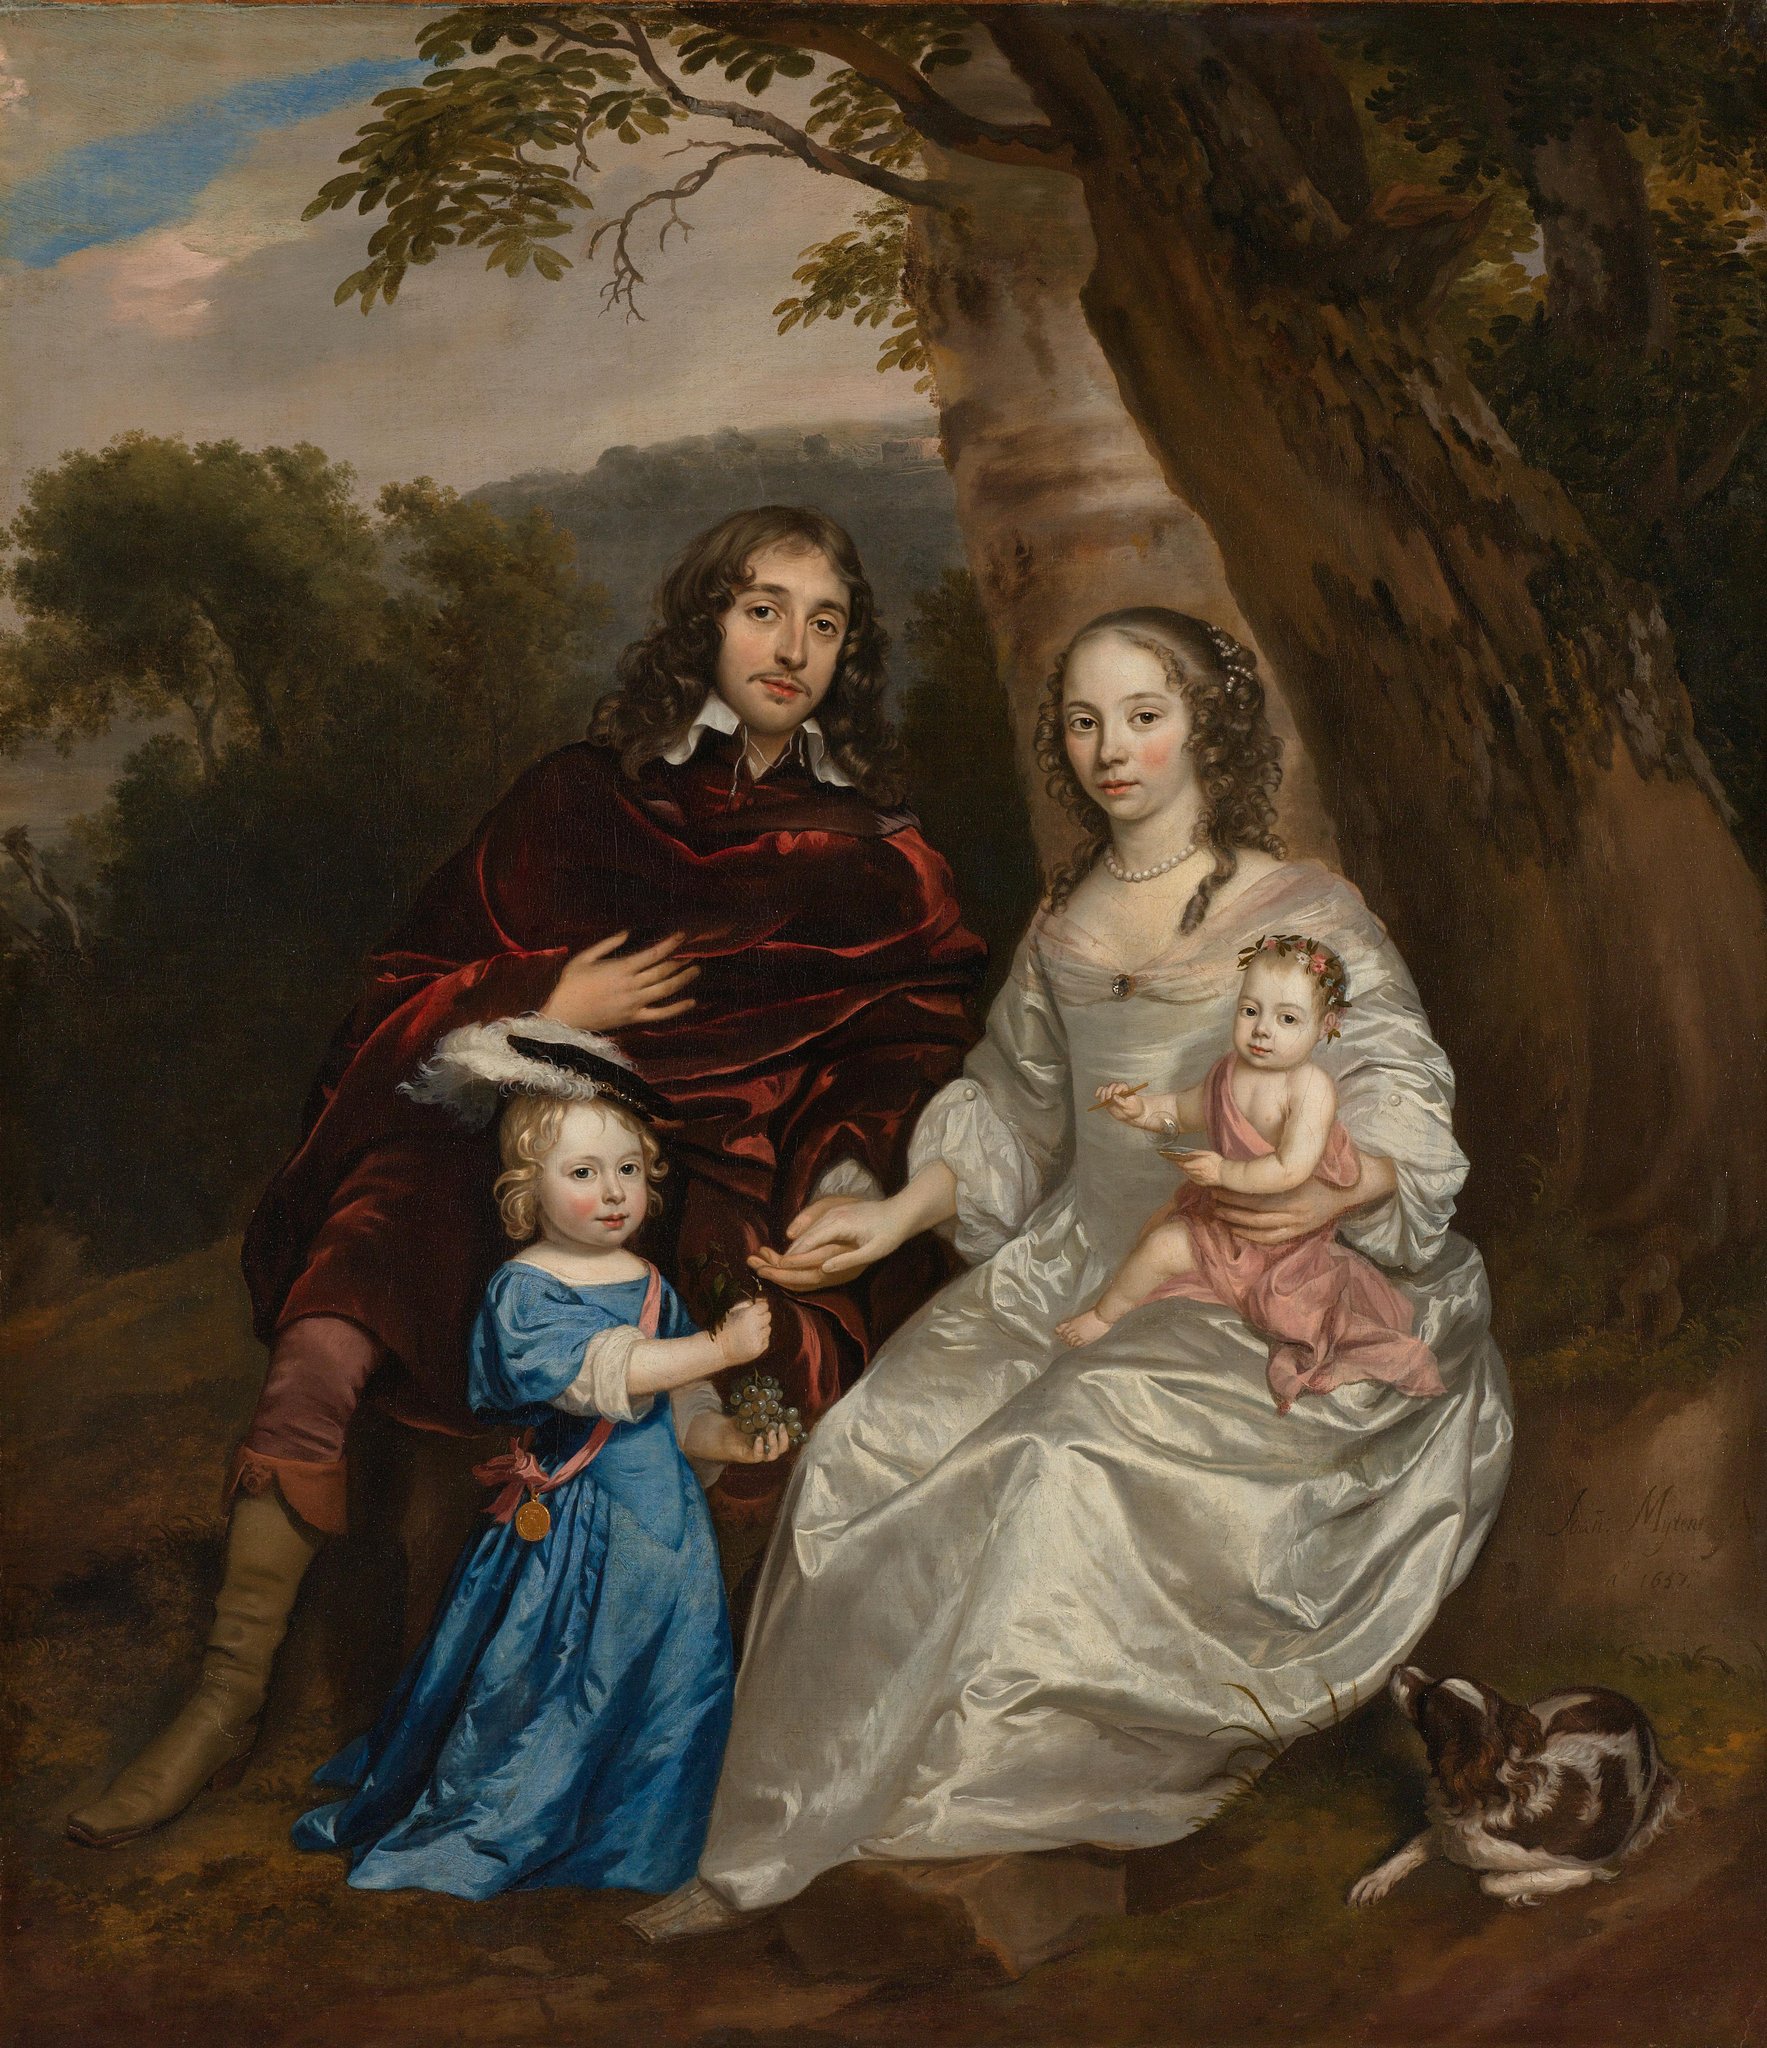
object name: painting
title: Portrait of Govert van Slingelandt (1623-1690), with his First Wife Christina van Beveren (1632-1656) and their Two Children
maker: jan mijtens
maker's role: painter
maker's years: 1614-1670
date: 1657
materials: canvas, oil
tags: dordrecht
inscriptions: signature and date, lower right: ‘Joan: Mijtens f. / a°: 1657.’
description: Familieportret van Govert van Slingelandt, heer van Dubbeldam, pensionaris van Dordrecht. Met zijn eerste vrouw Christina van Beveren en hun beide zoontjes Barthoud en Govert Johan van Slingelandt zittend onder een boom in een landschap. De oudste zoon heeft een tros druiven in de handen. De jongste zoon zit bij zijn moeder op schoot en blaast bellen. Rechts een hondje.